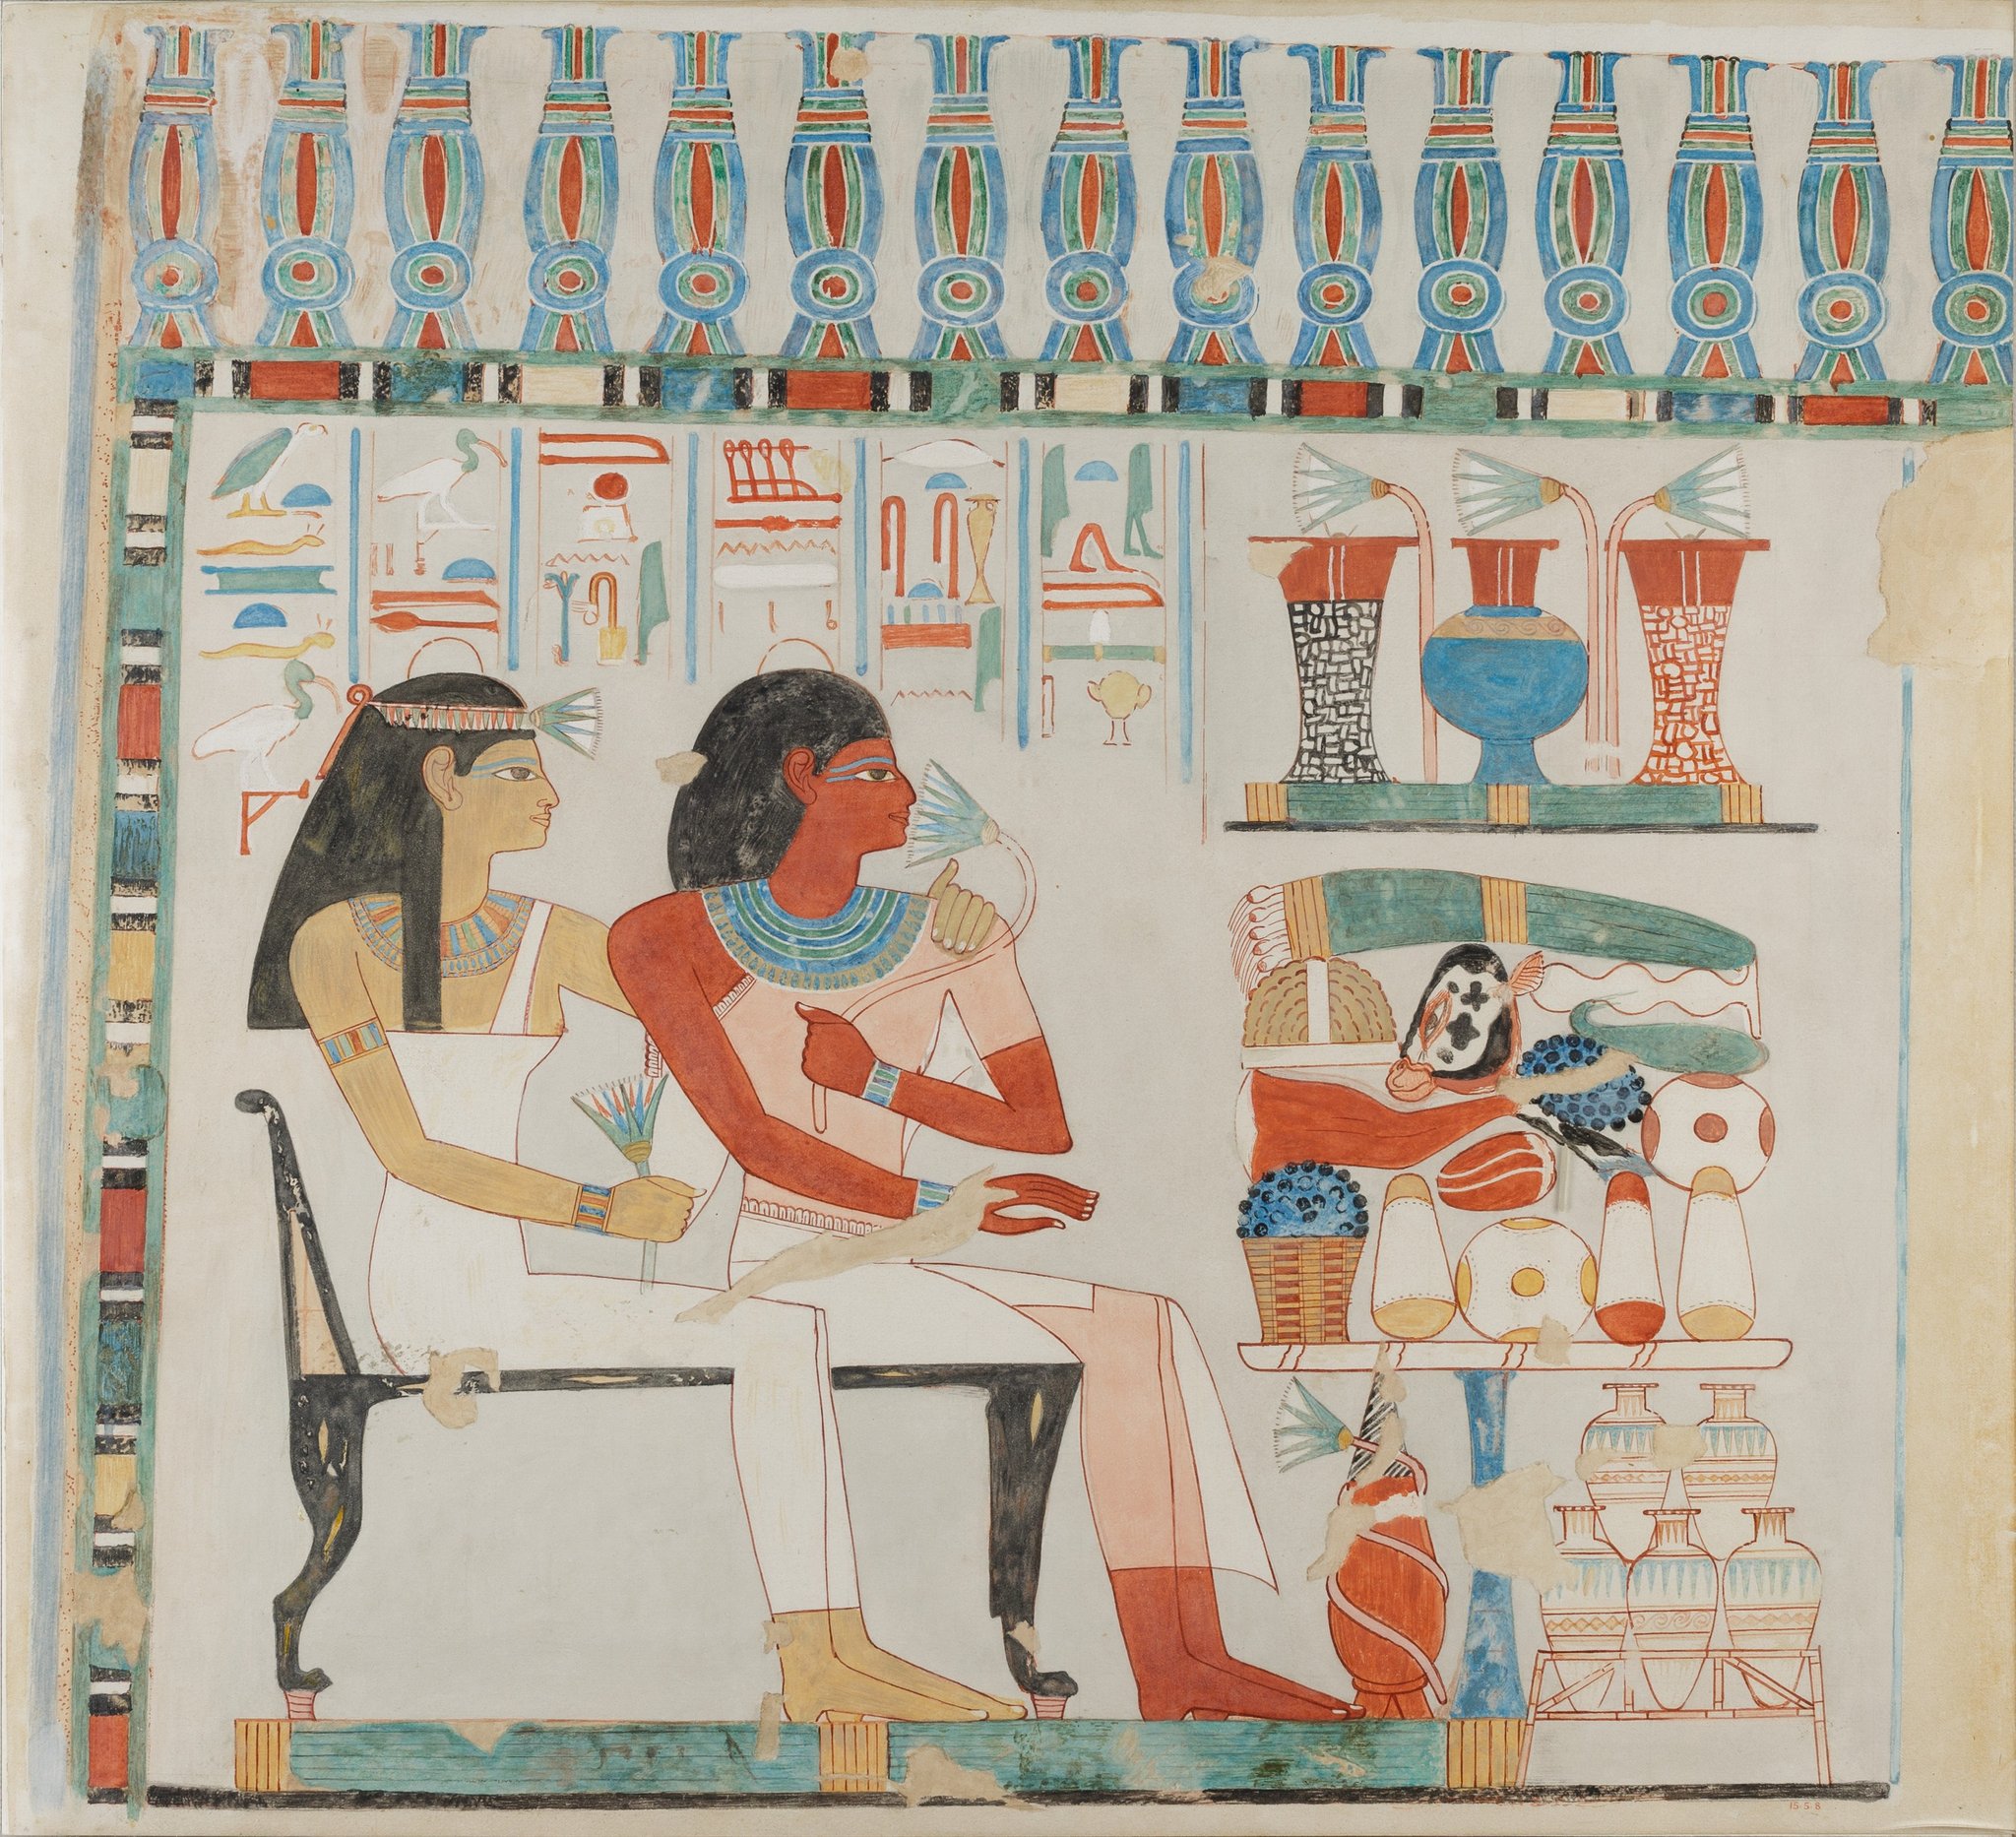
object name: facsimile, djehuty tt 45, offering scene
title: Djehuty and his Mother Receiving Offerings, Tomb of Djehuty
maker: norman de garis davies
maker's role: artist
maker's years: 1865-1941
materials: paper, paint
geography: egypt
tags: women,hieroglyphs,walk-like-egyptian